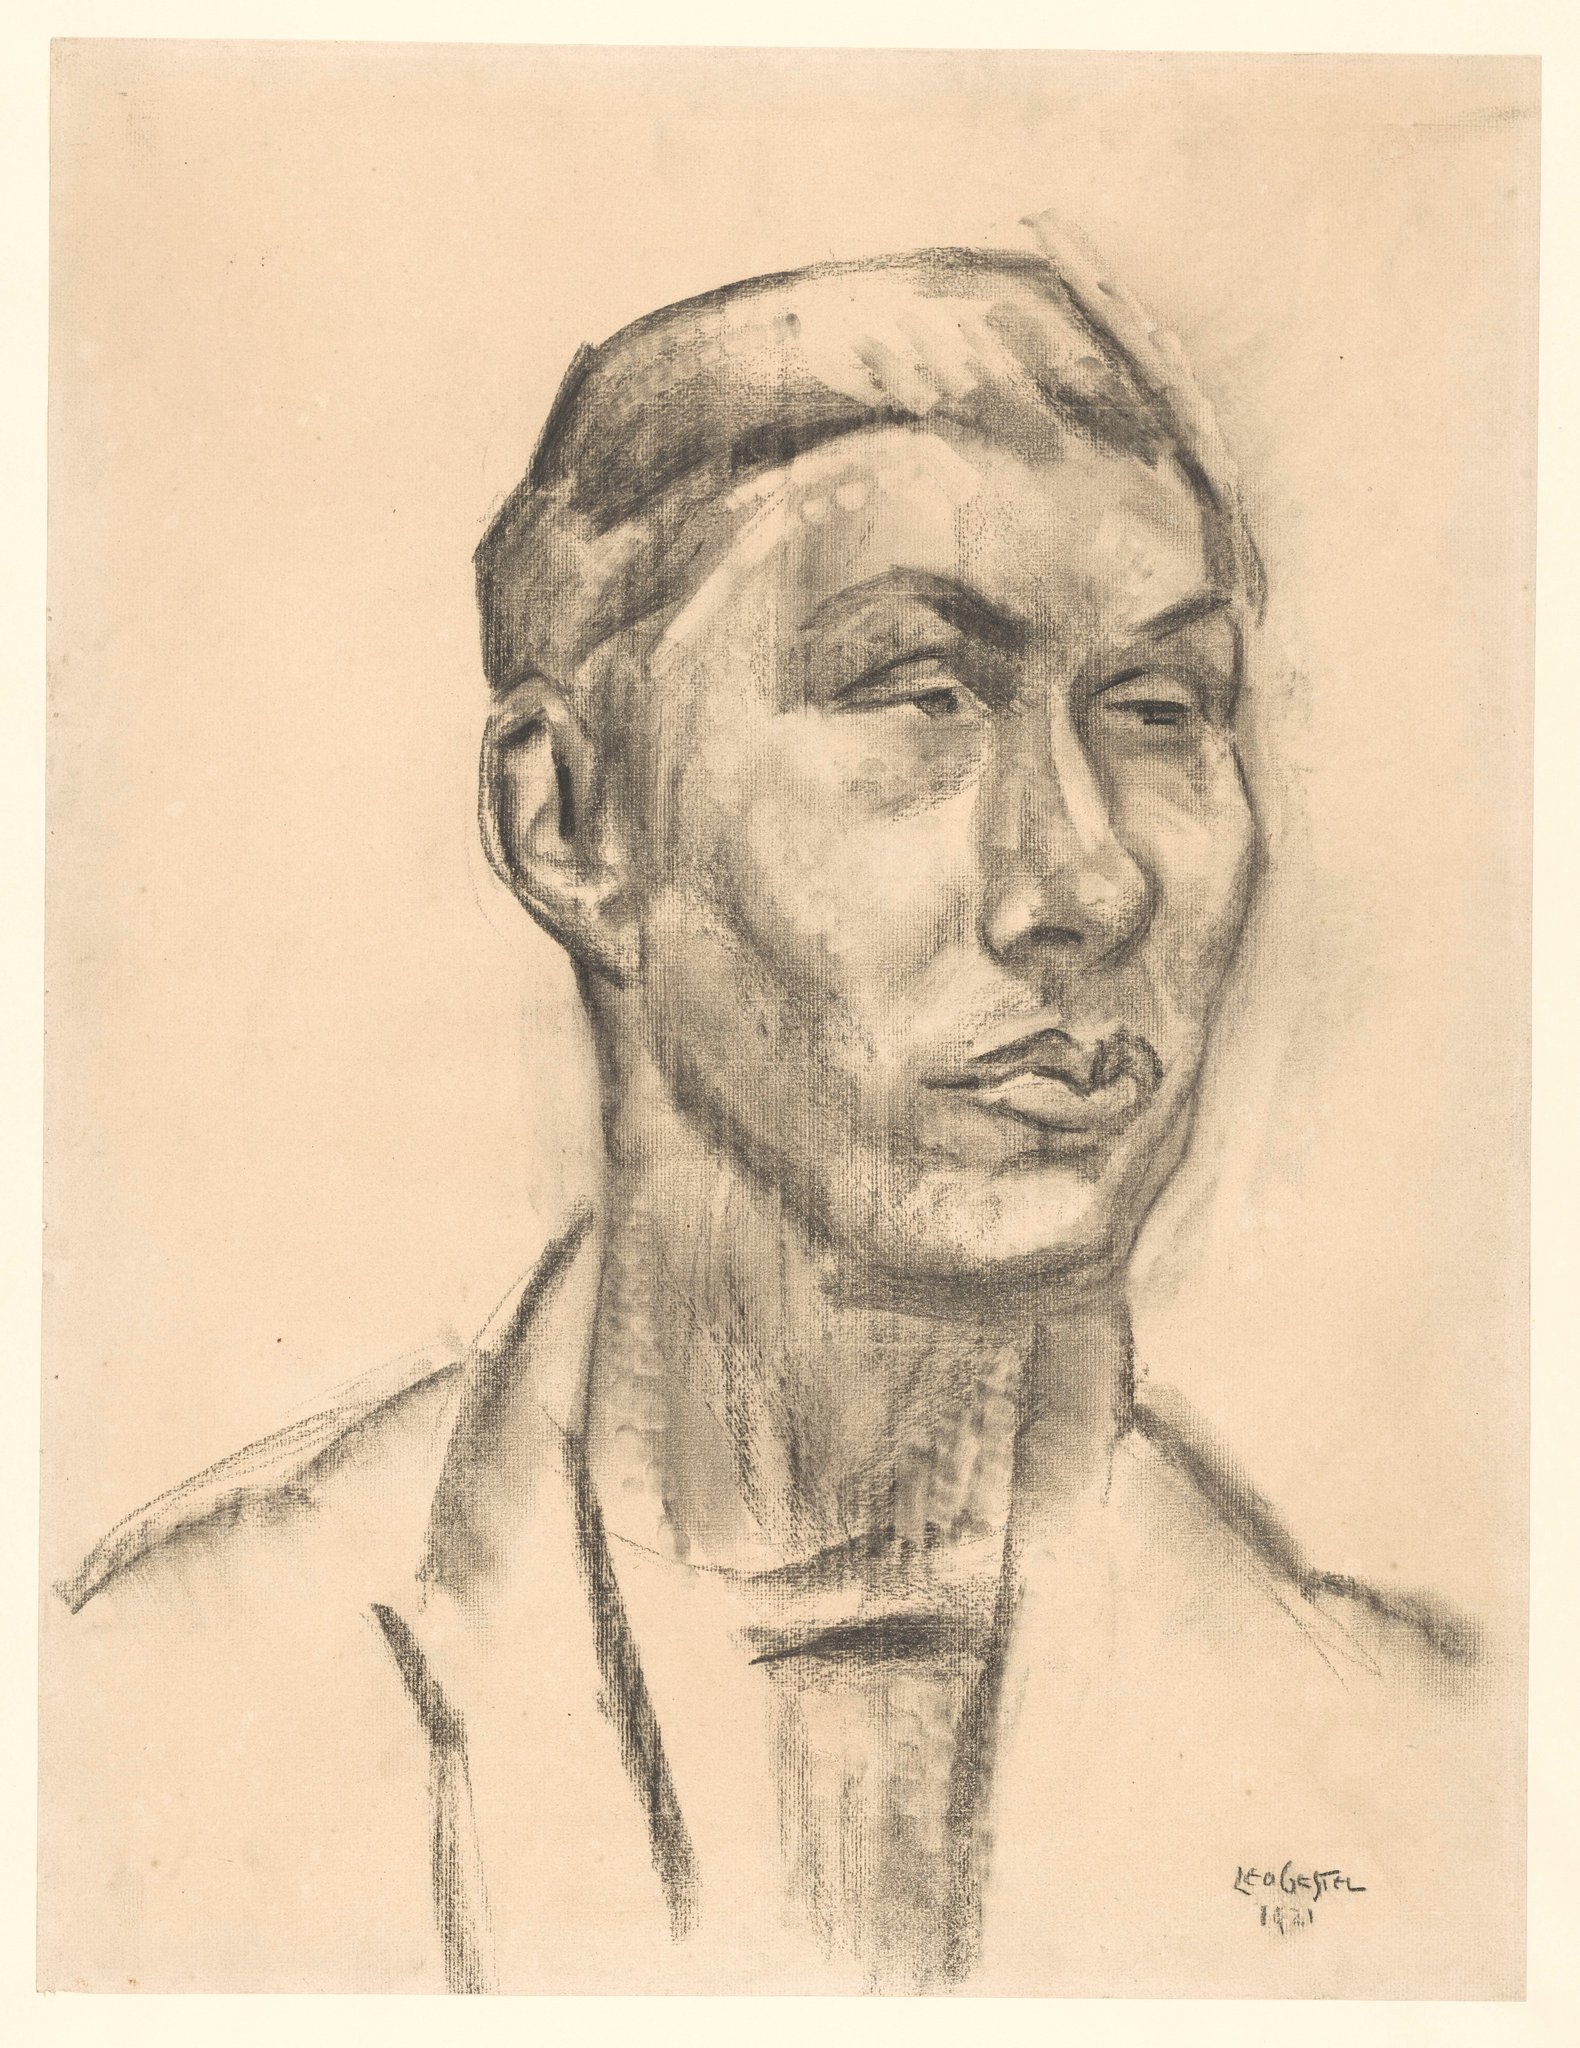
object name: drawing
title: Portret van een onbekende man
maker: leo gestel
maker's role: draughtsman, print maker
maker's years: 1881-1941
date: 1921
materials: charcoal, paper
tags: anonymous historical person portrayed alone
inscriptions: collector's mark: Lugt 2228